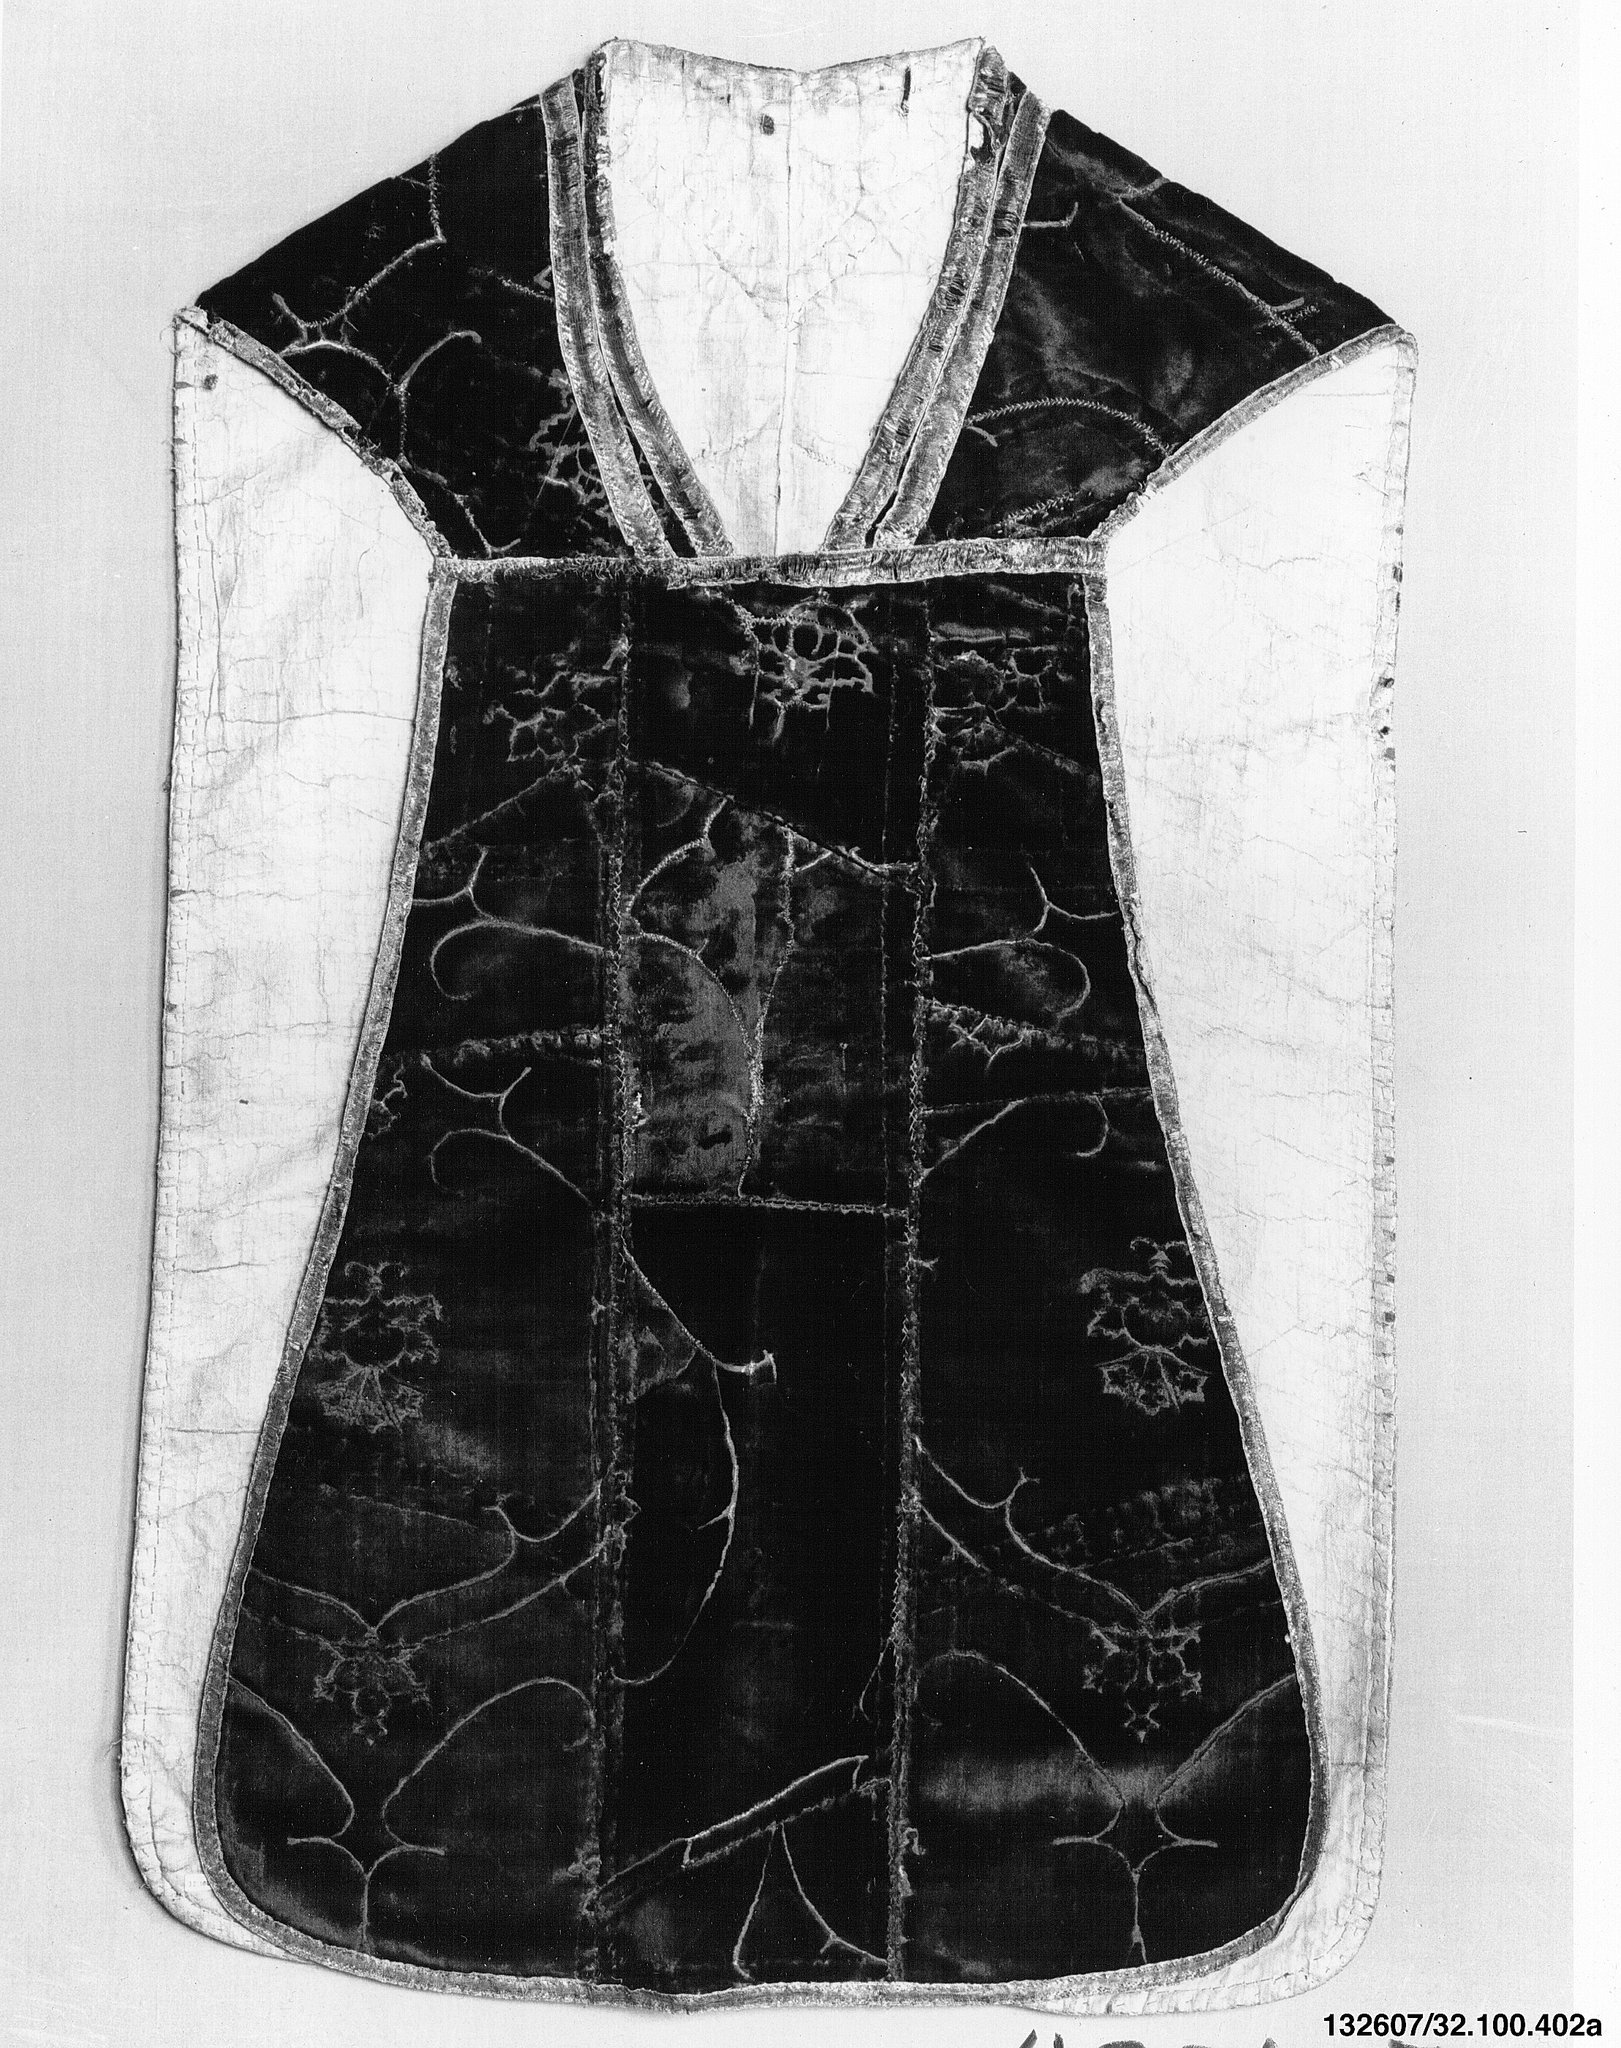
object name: panel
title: Panels (2)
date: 1401-1500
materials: silk